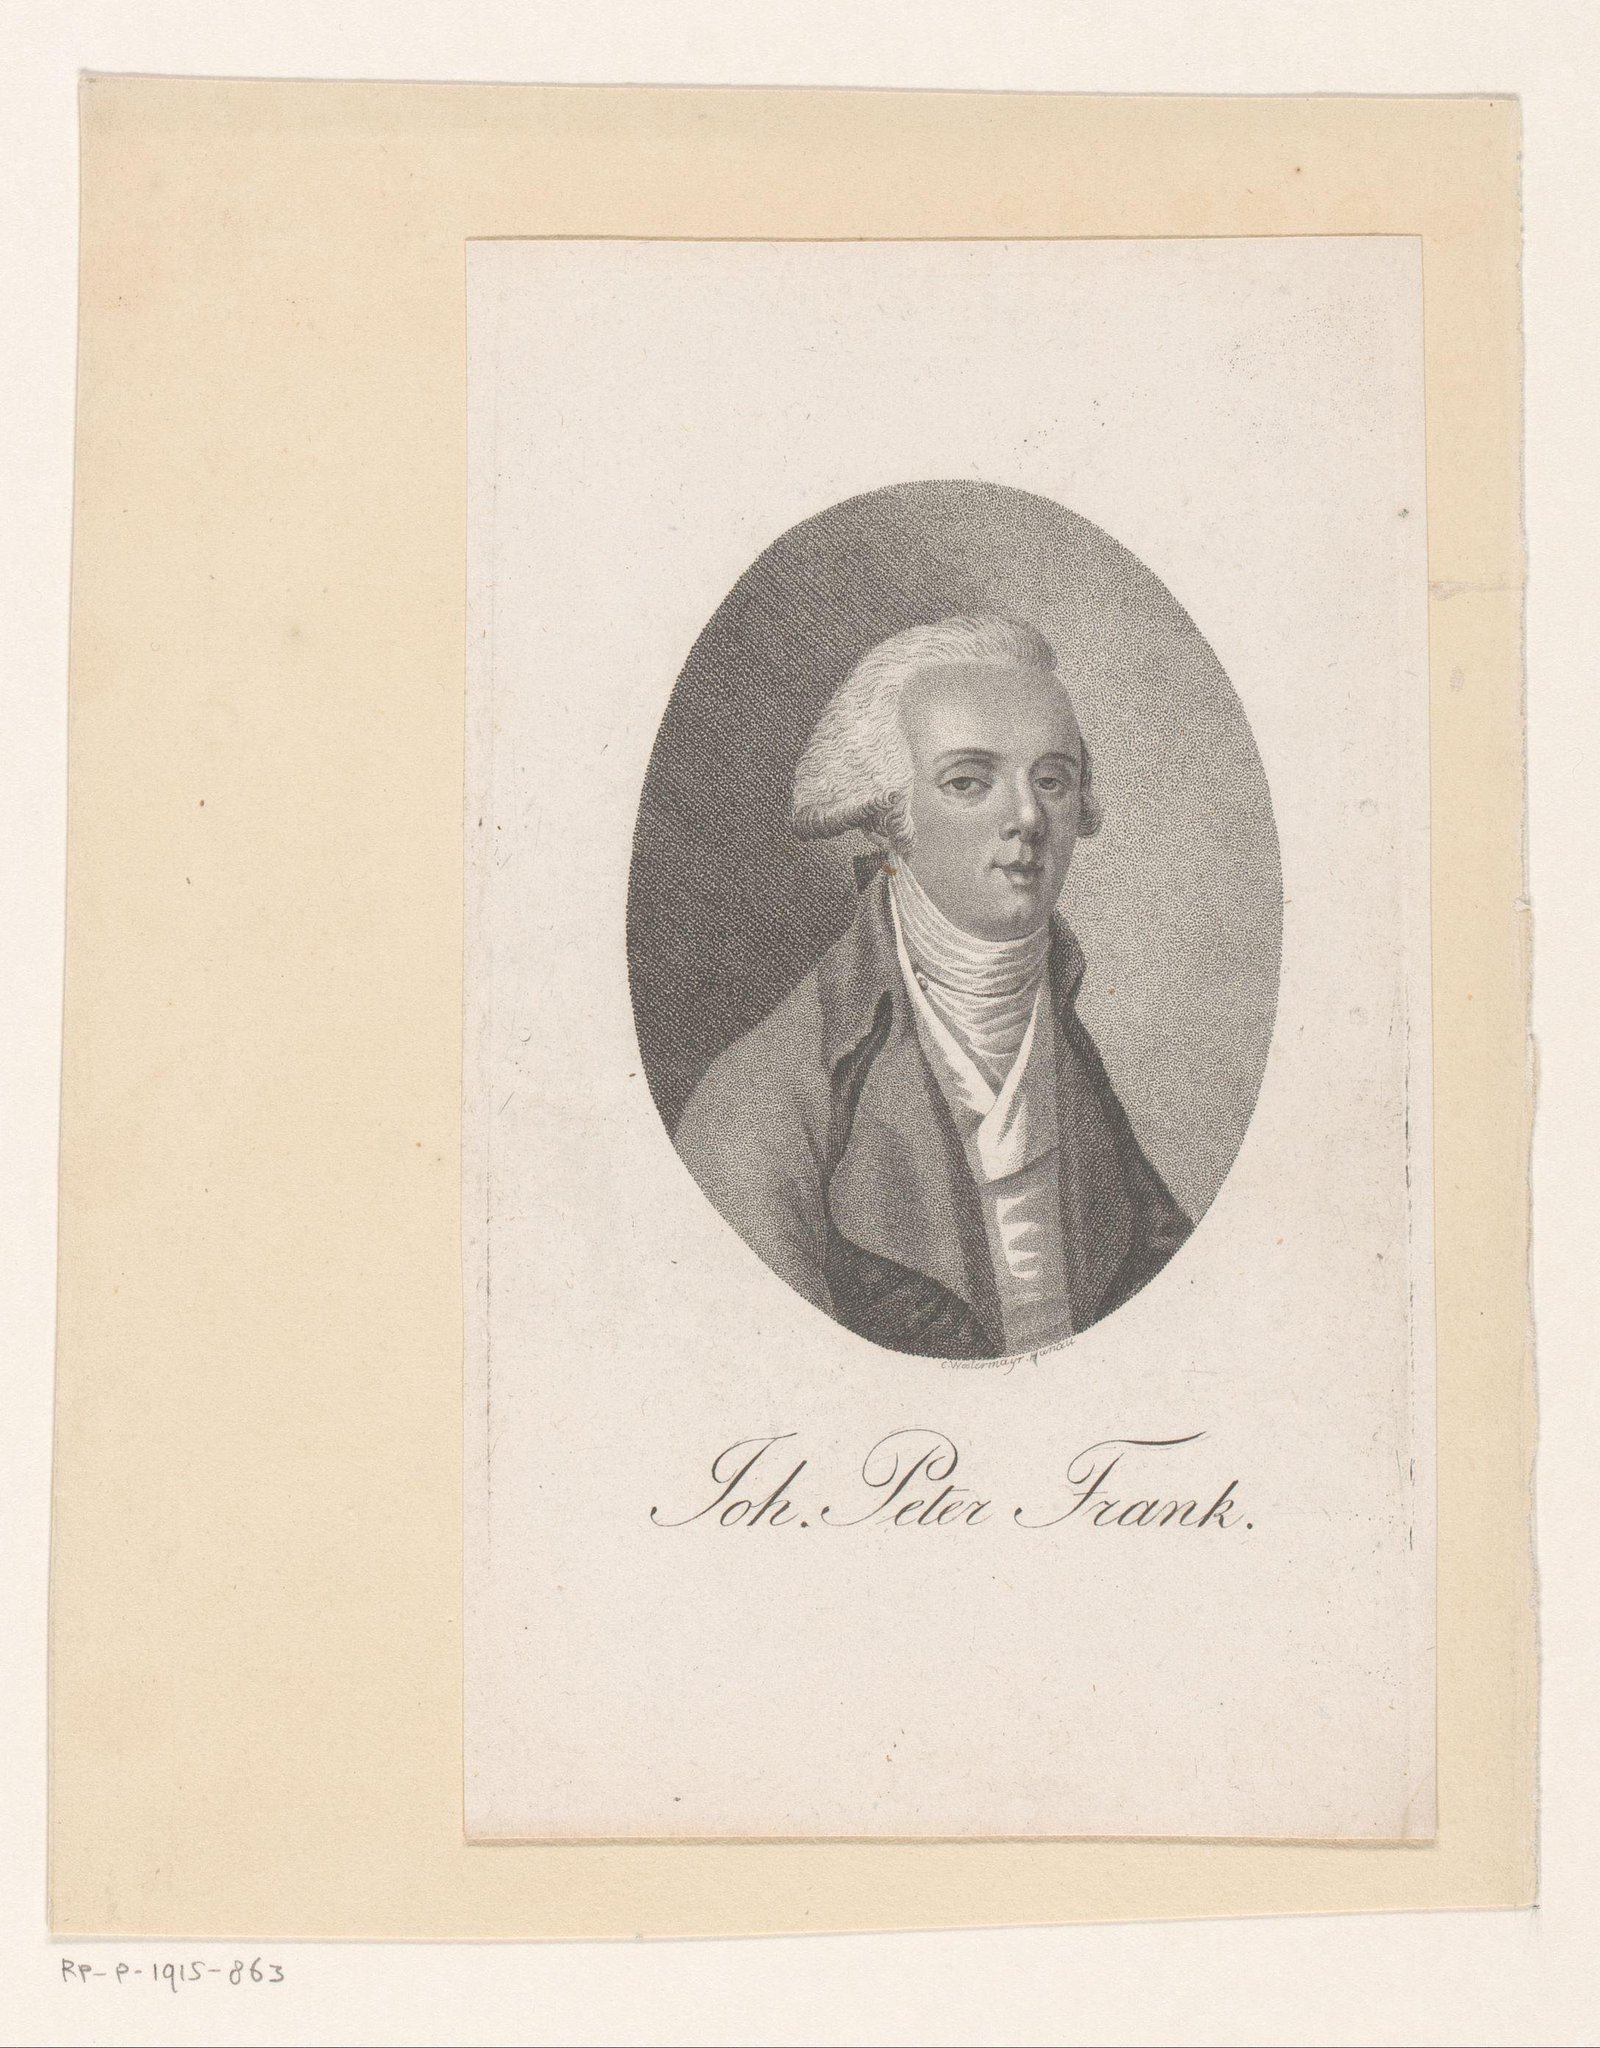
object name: print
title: Portret van Johann Peter Frank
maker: konrad westermayr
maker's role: print maker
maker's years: 1765-1834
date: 1775-1834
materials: paper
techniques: engraving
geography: hanau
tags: historical persons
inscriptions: collector's mark: Lugt 2228